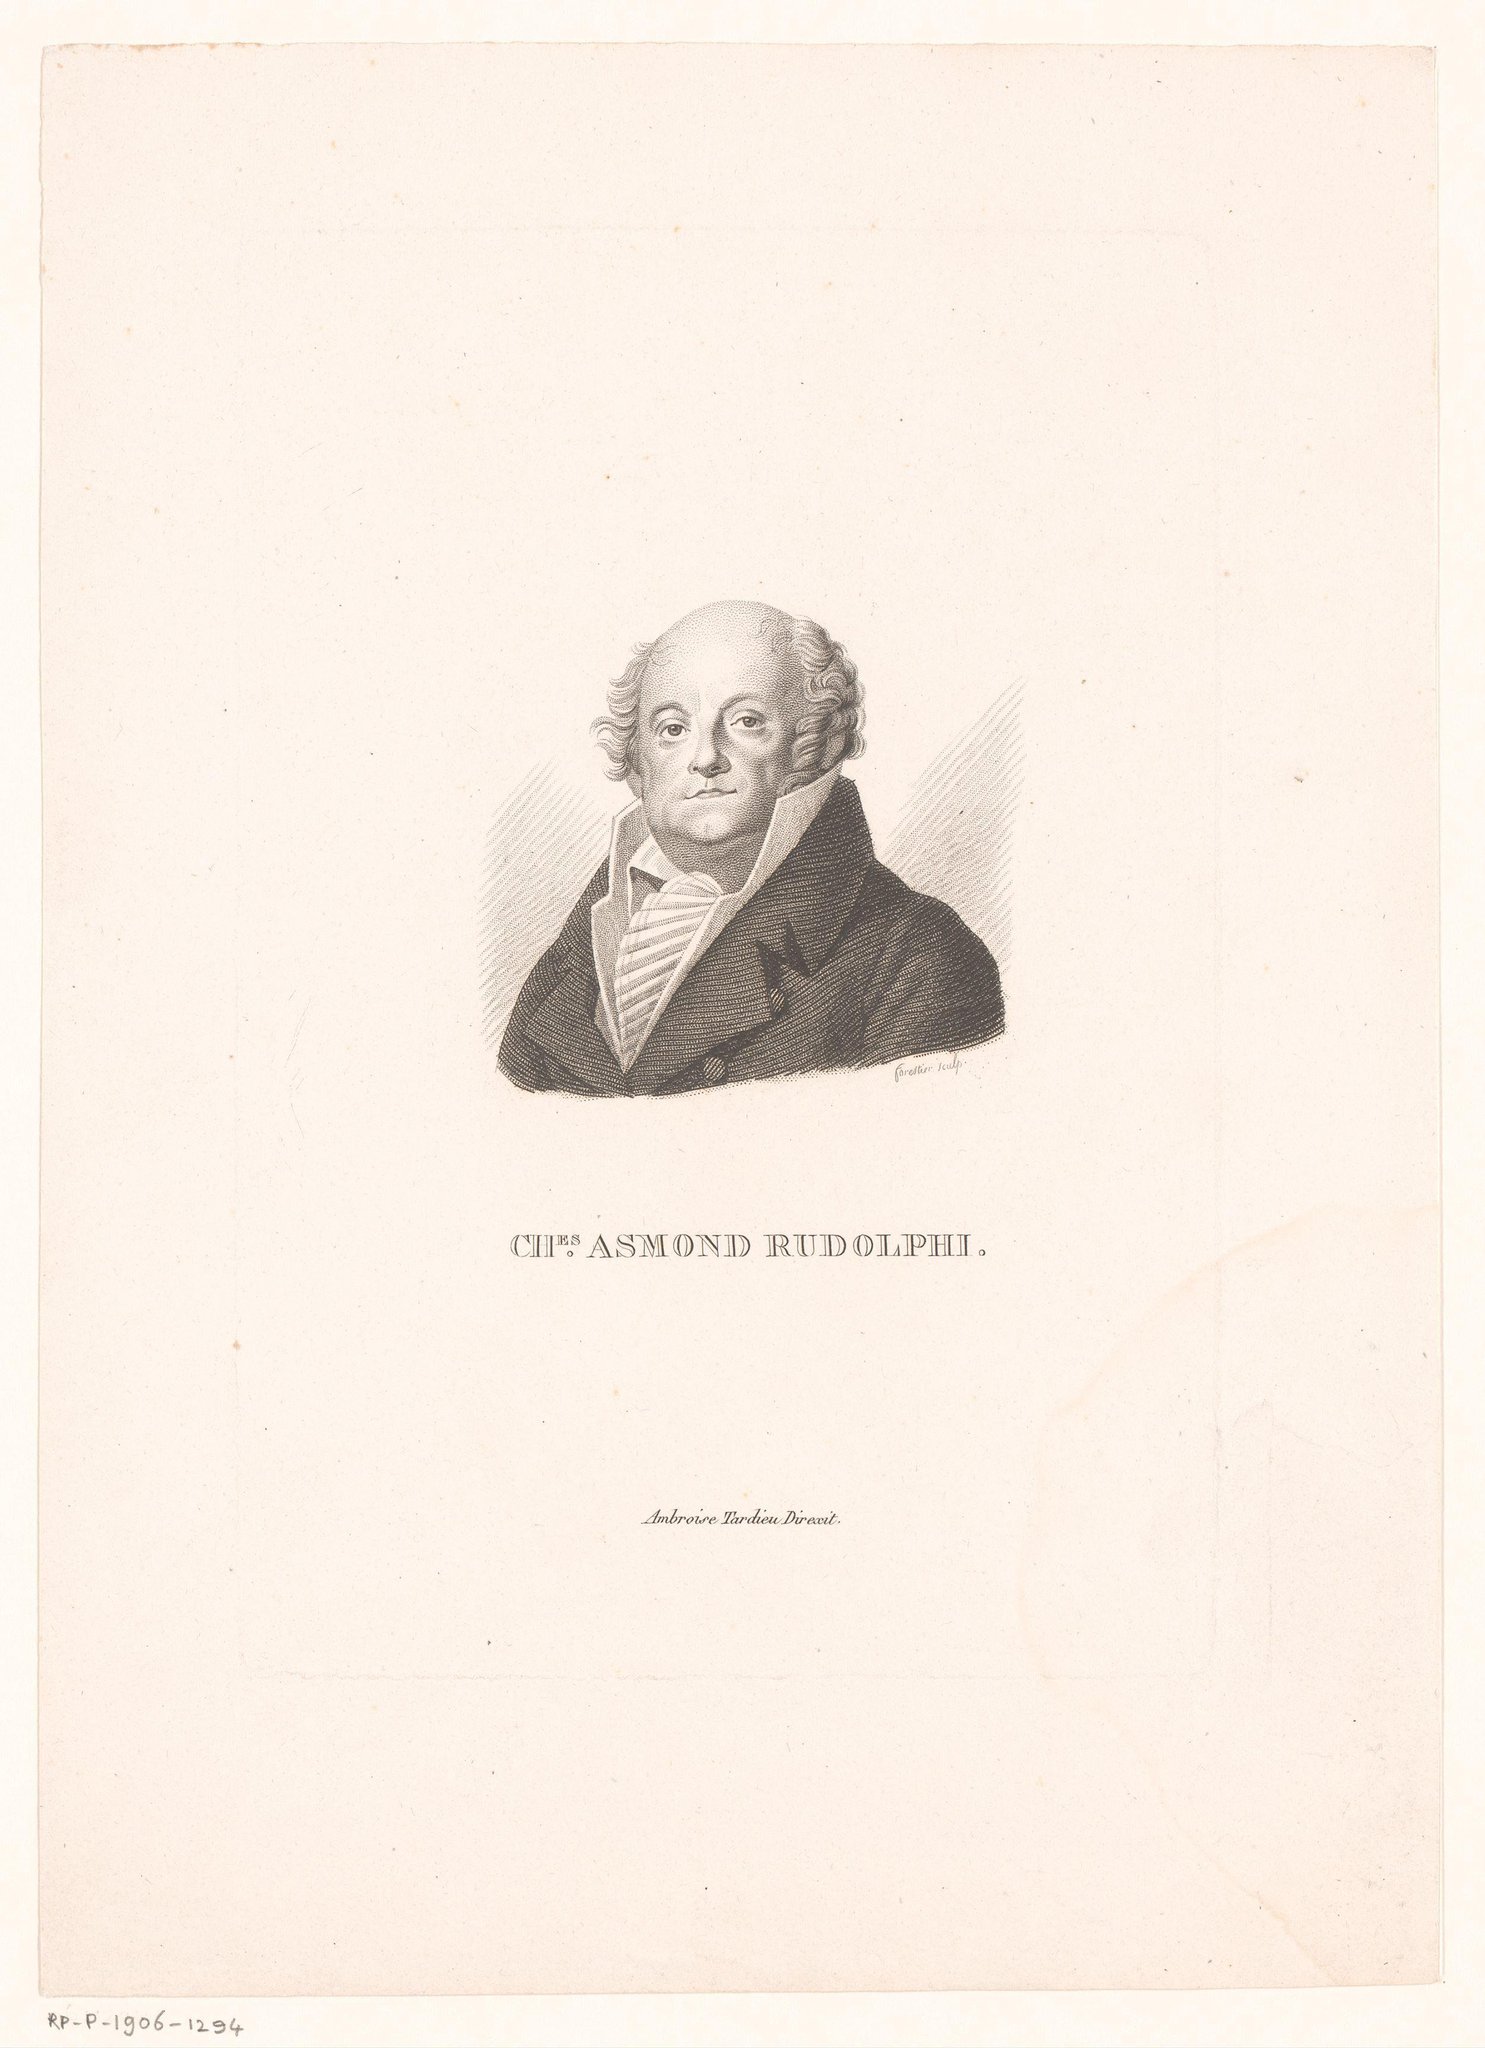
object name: print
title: Portret van Karl Asmund Rudolphi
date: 1818-1832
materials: paper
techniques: etching, roulette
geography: france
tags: berlin, scholar, philosopher, historical persons, physician, doctor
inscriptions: collector's mark: Lugt 2228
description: Mogelijk prent uit: Journal complémentaire du Dictionnaire des sciences médicales. Parijs: Panckoucke, Charles Louis Fleury, 1818-1832.